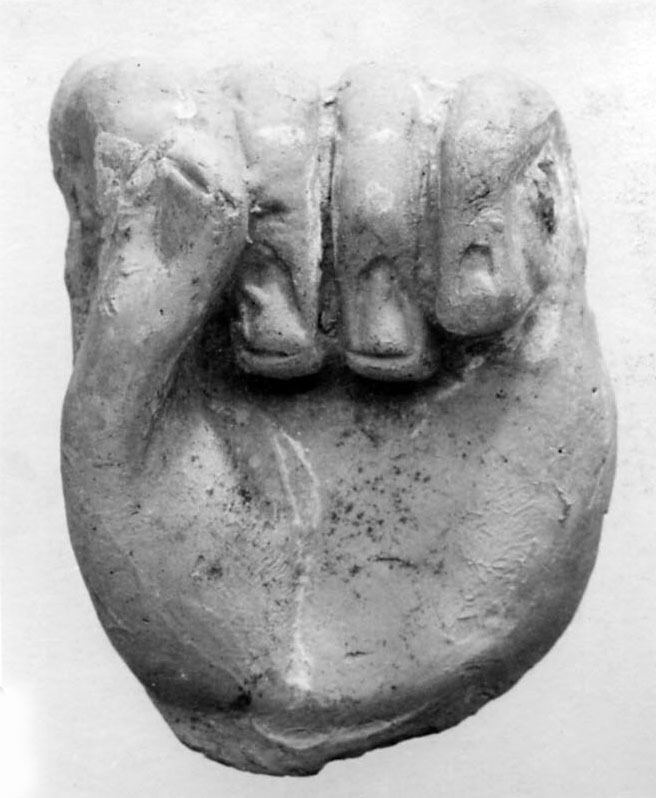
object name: relief fragment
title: Fragment of a Statue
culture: central asian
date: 201-700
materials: clay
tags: hands